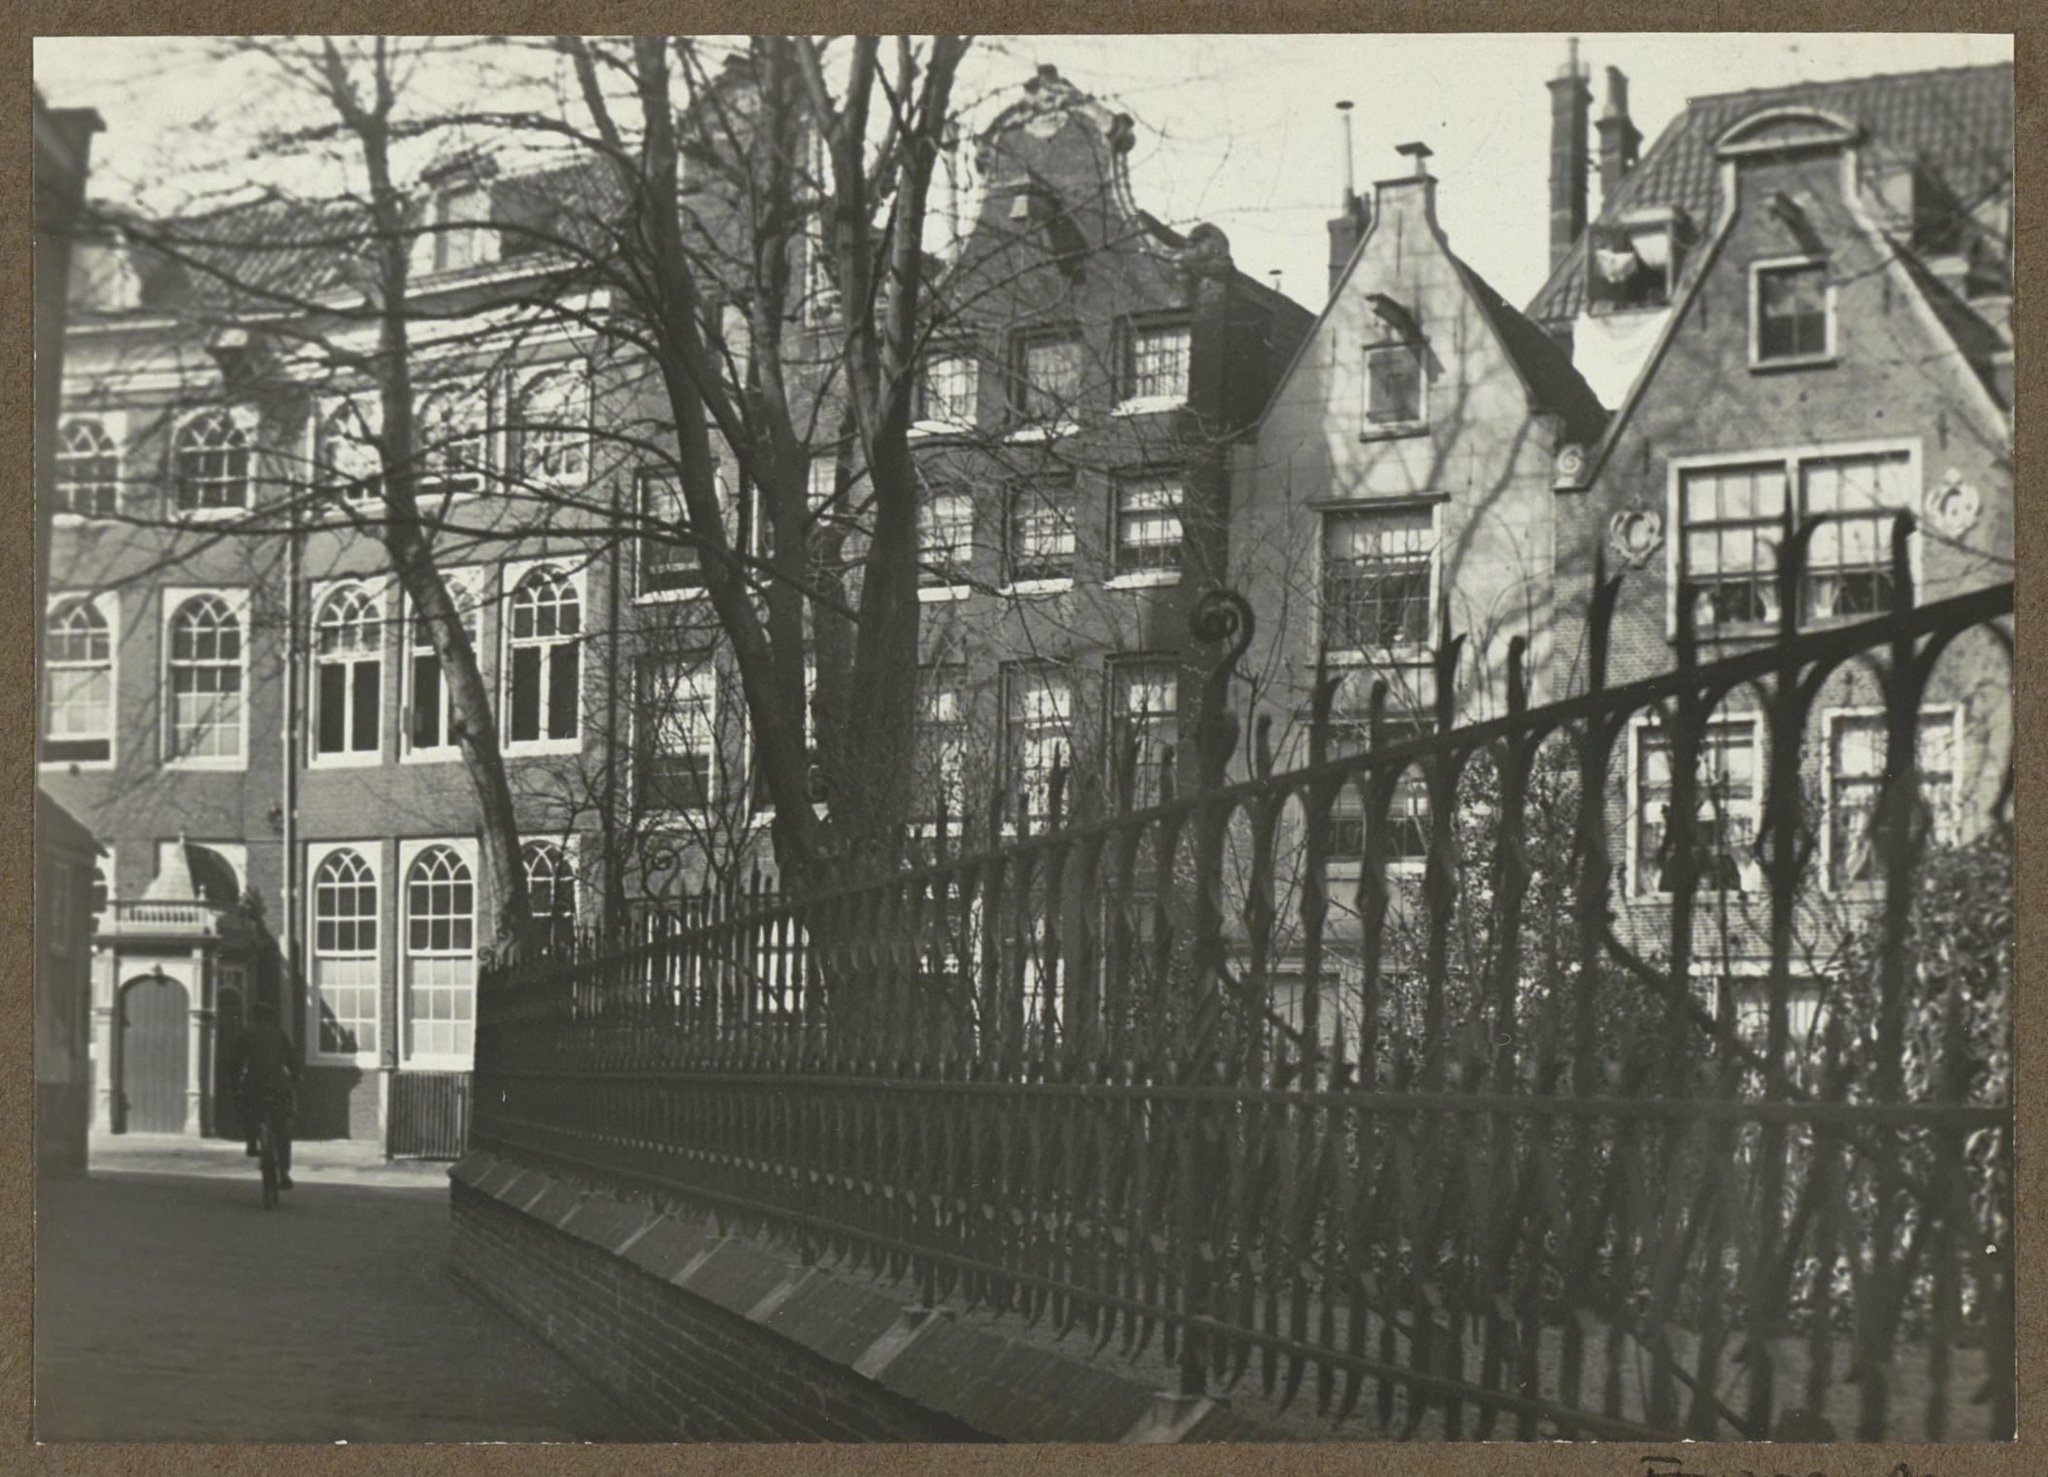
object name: photograph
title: Huizen en de Begijnhofkapel (links) aan het Begijnhof te Amsterdam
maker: Anonymous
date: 1910-1930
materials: paper, photographic support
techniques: gelatin silver print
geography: amsterdam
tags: fence, wall, paling, church (exterior) - qq - small church, chapel, amsterdam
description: Onderdeel van Album met foto's van Amsterdam en omgeving.